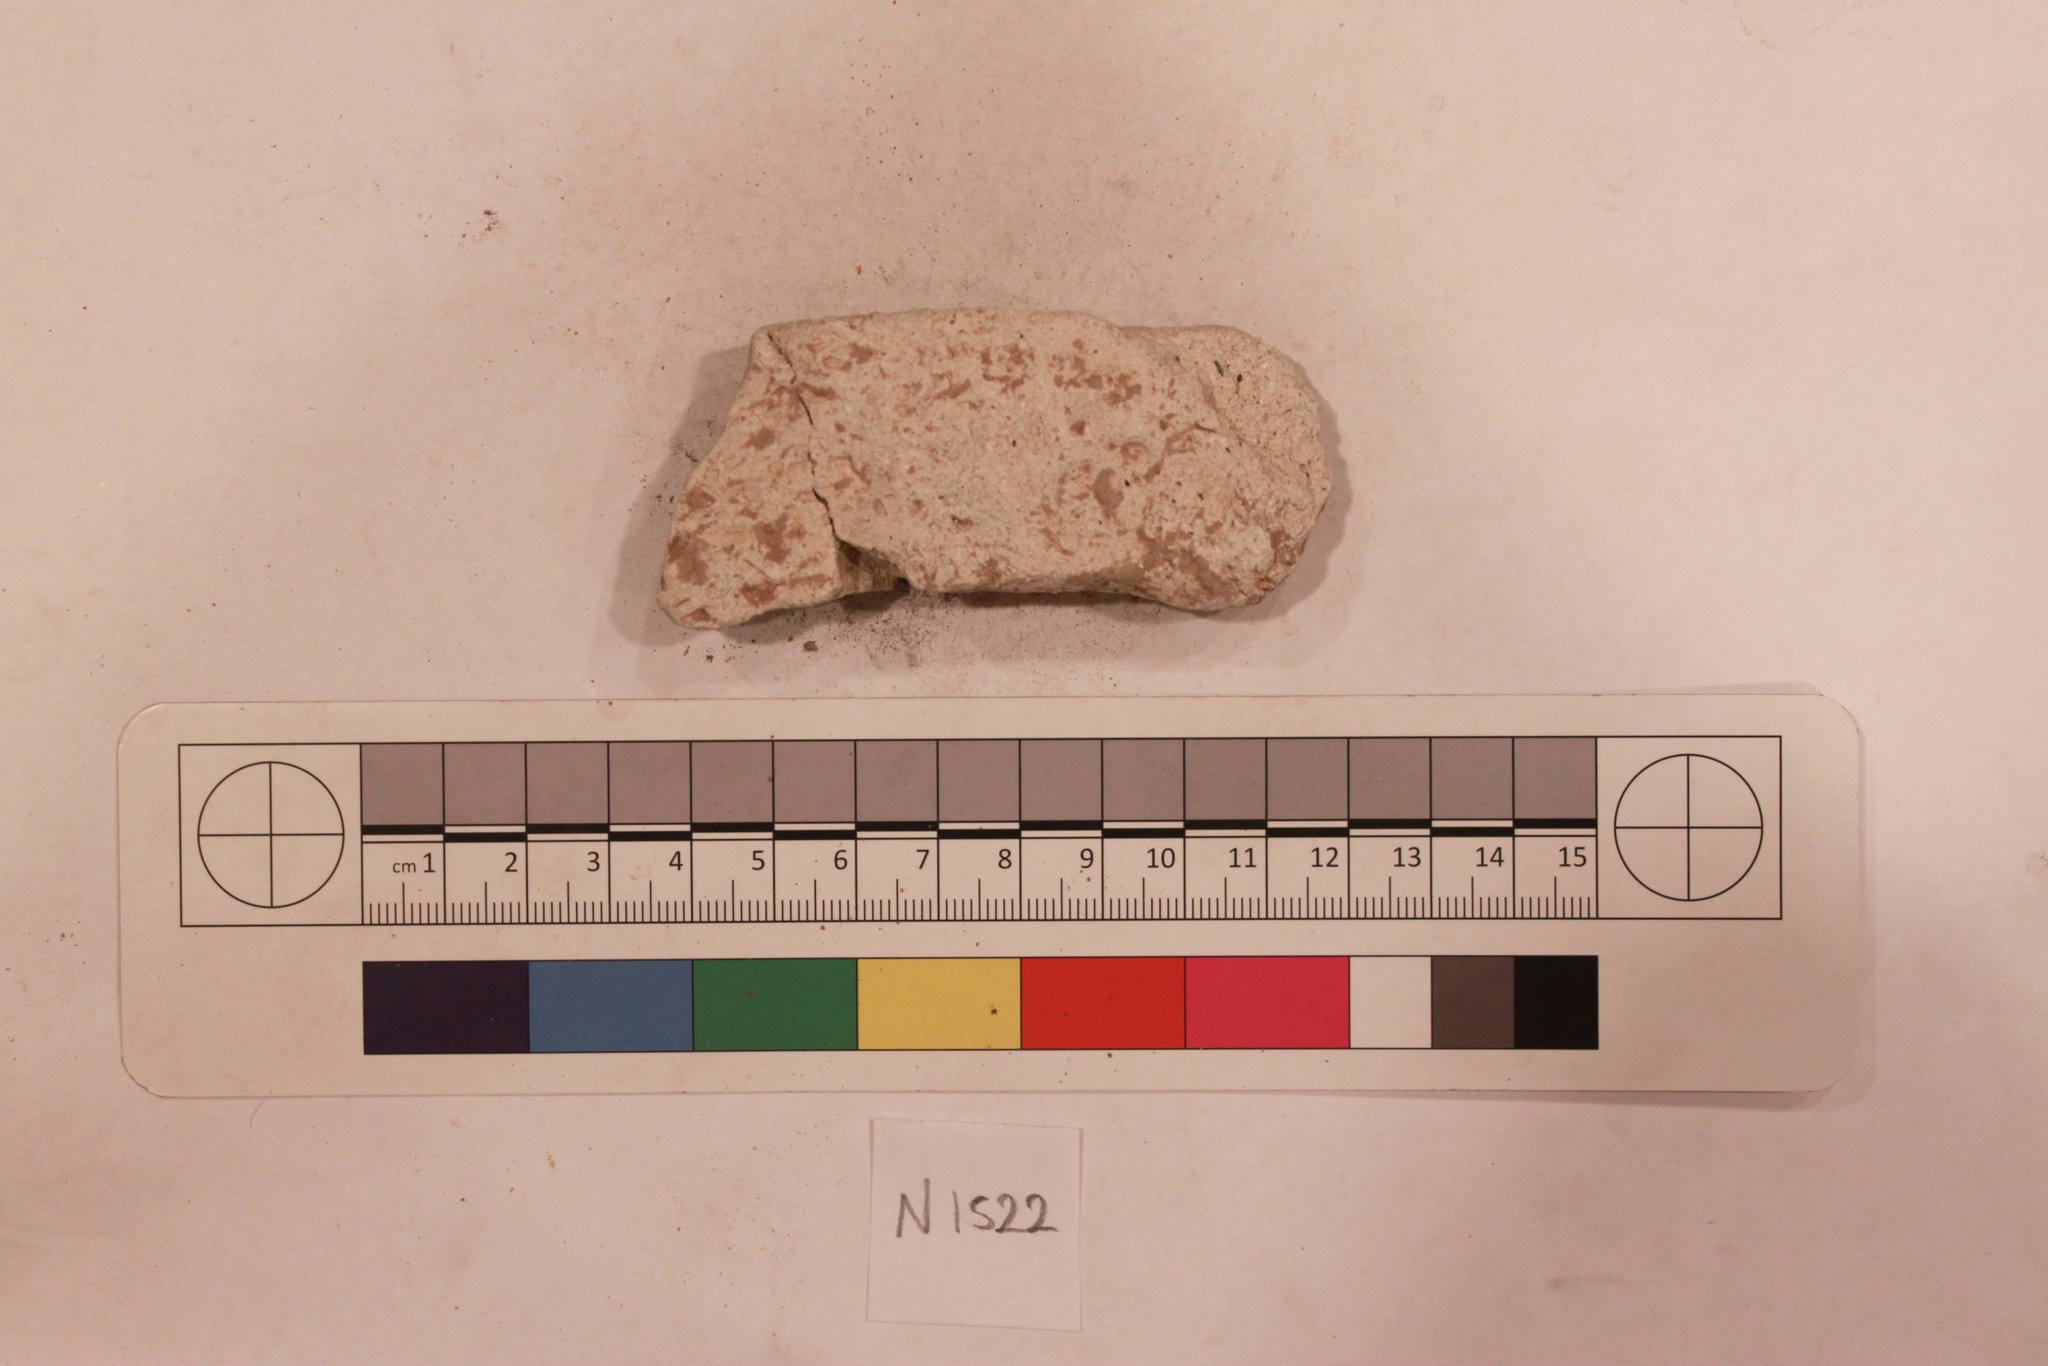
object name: fragment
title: Stucco Fragment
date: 701-1200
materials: plaster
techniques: carving, painting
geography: iran